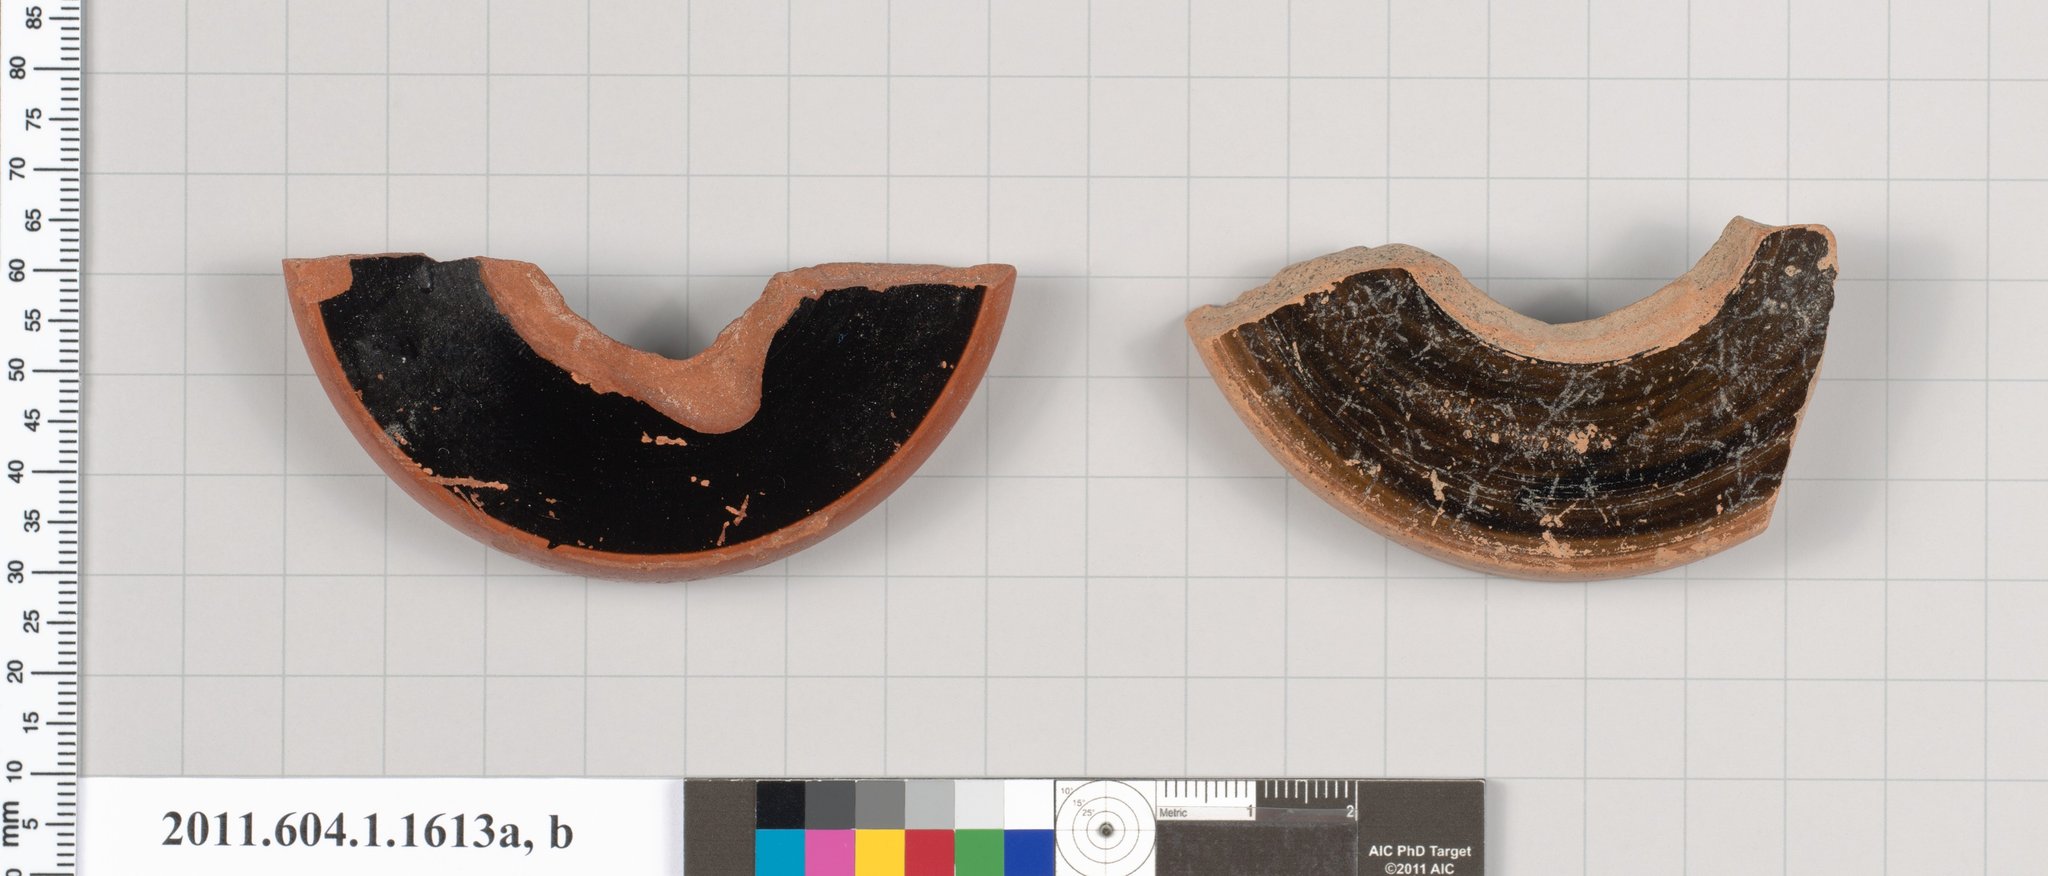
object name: kylix fragment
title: Terracotta fragments of kylikes (drinking cups)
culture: greek, attic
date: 500-401 BCE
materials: terracotta